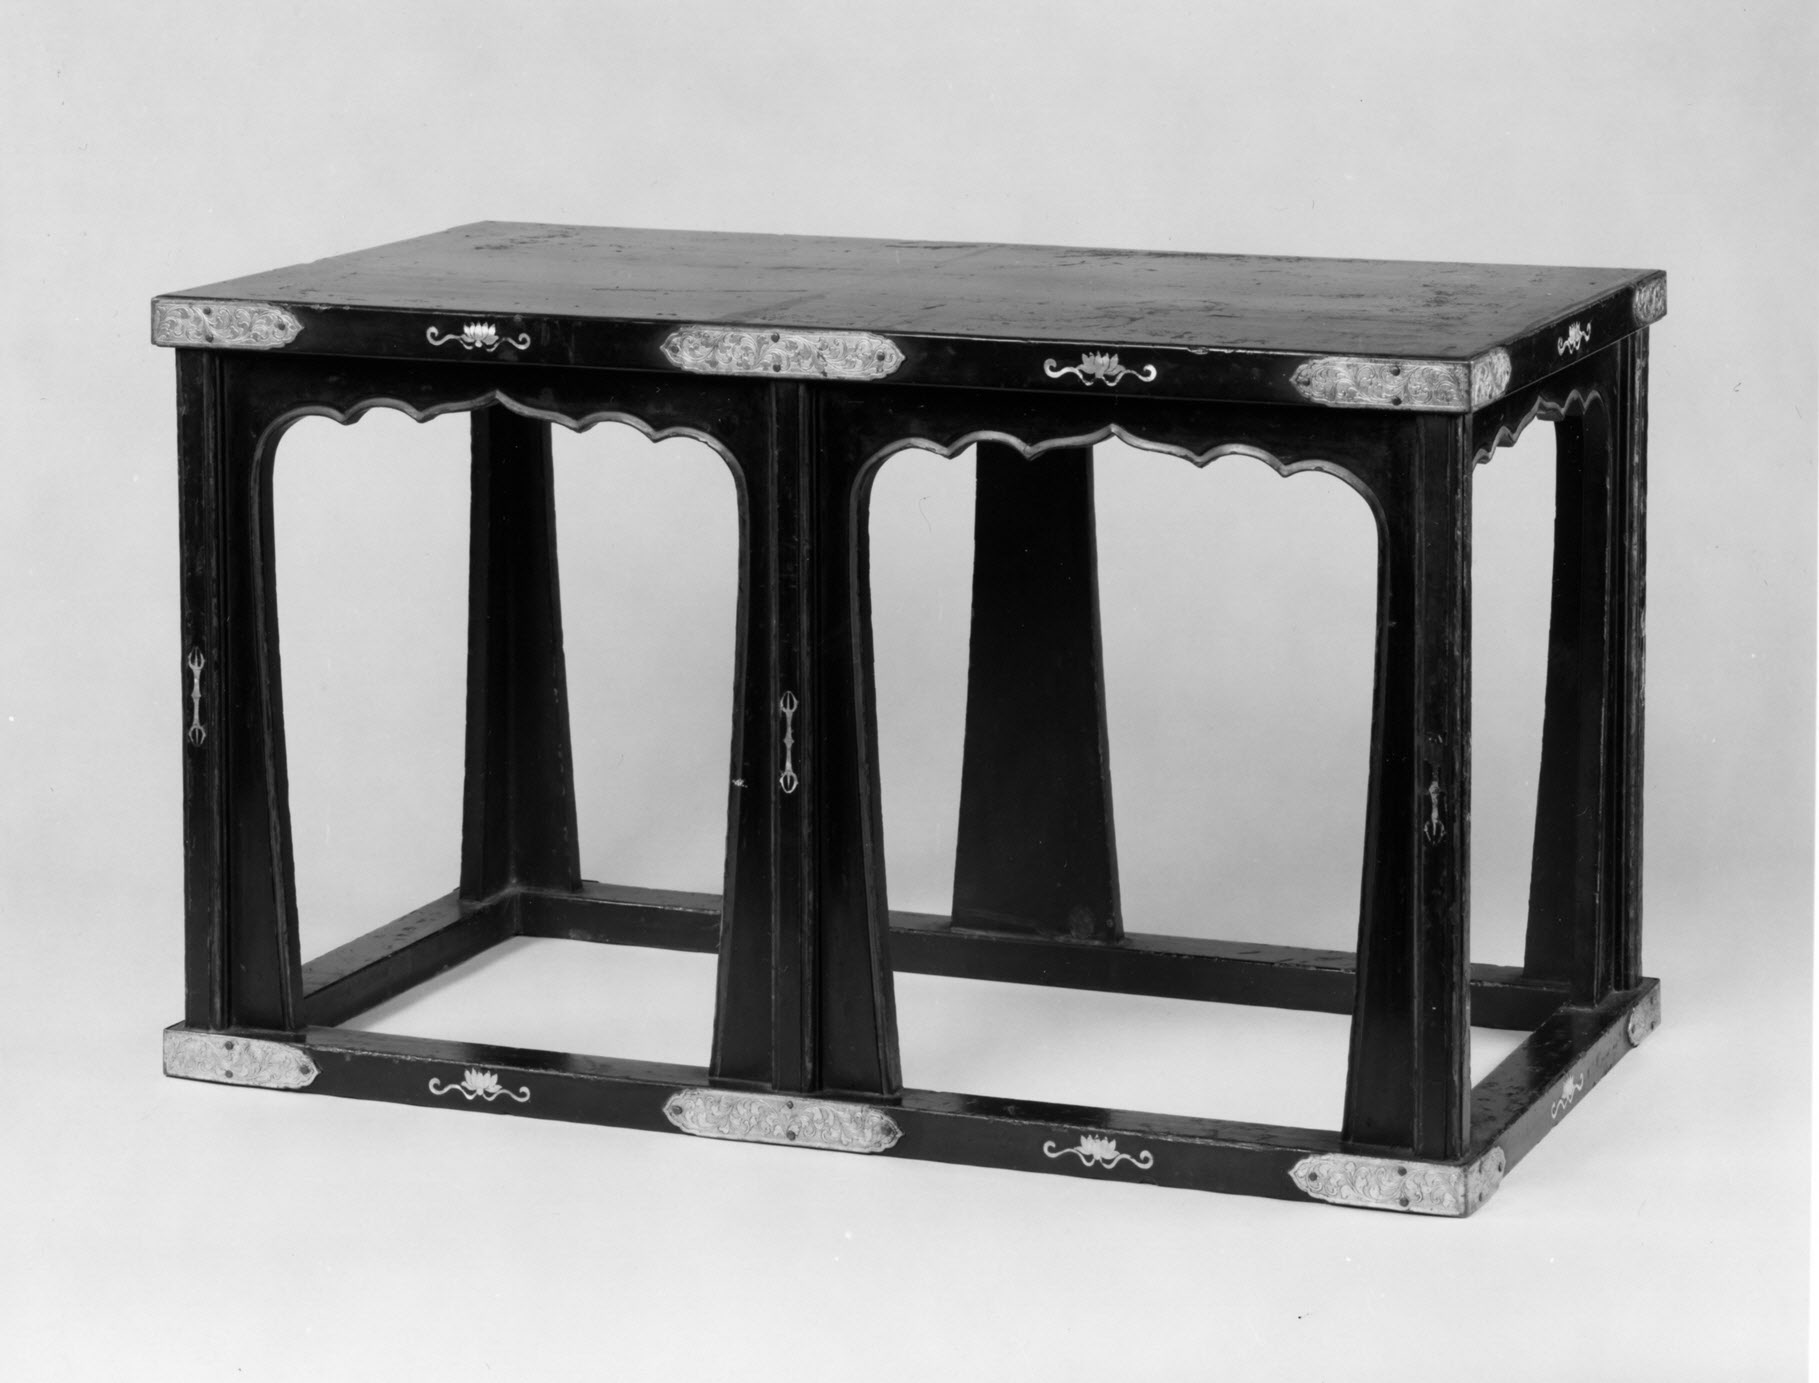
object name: altar table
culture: japanese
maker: unidentified artist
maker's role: artist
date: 1651-1700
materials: gilt bronze, lacquer, mother of pearl, wood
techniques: inlay